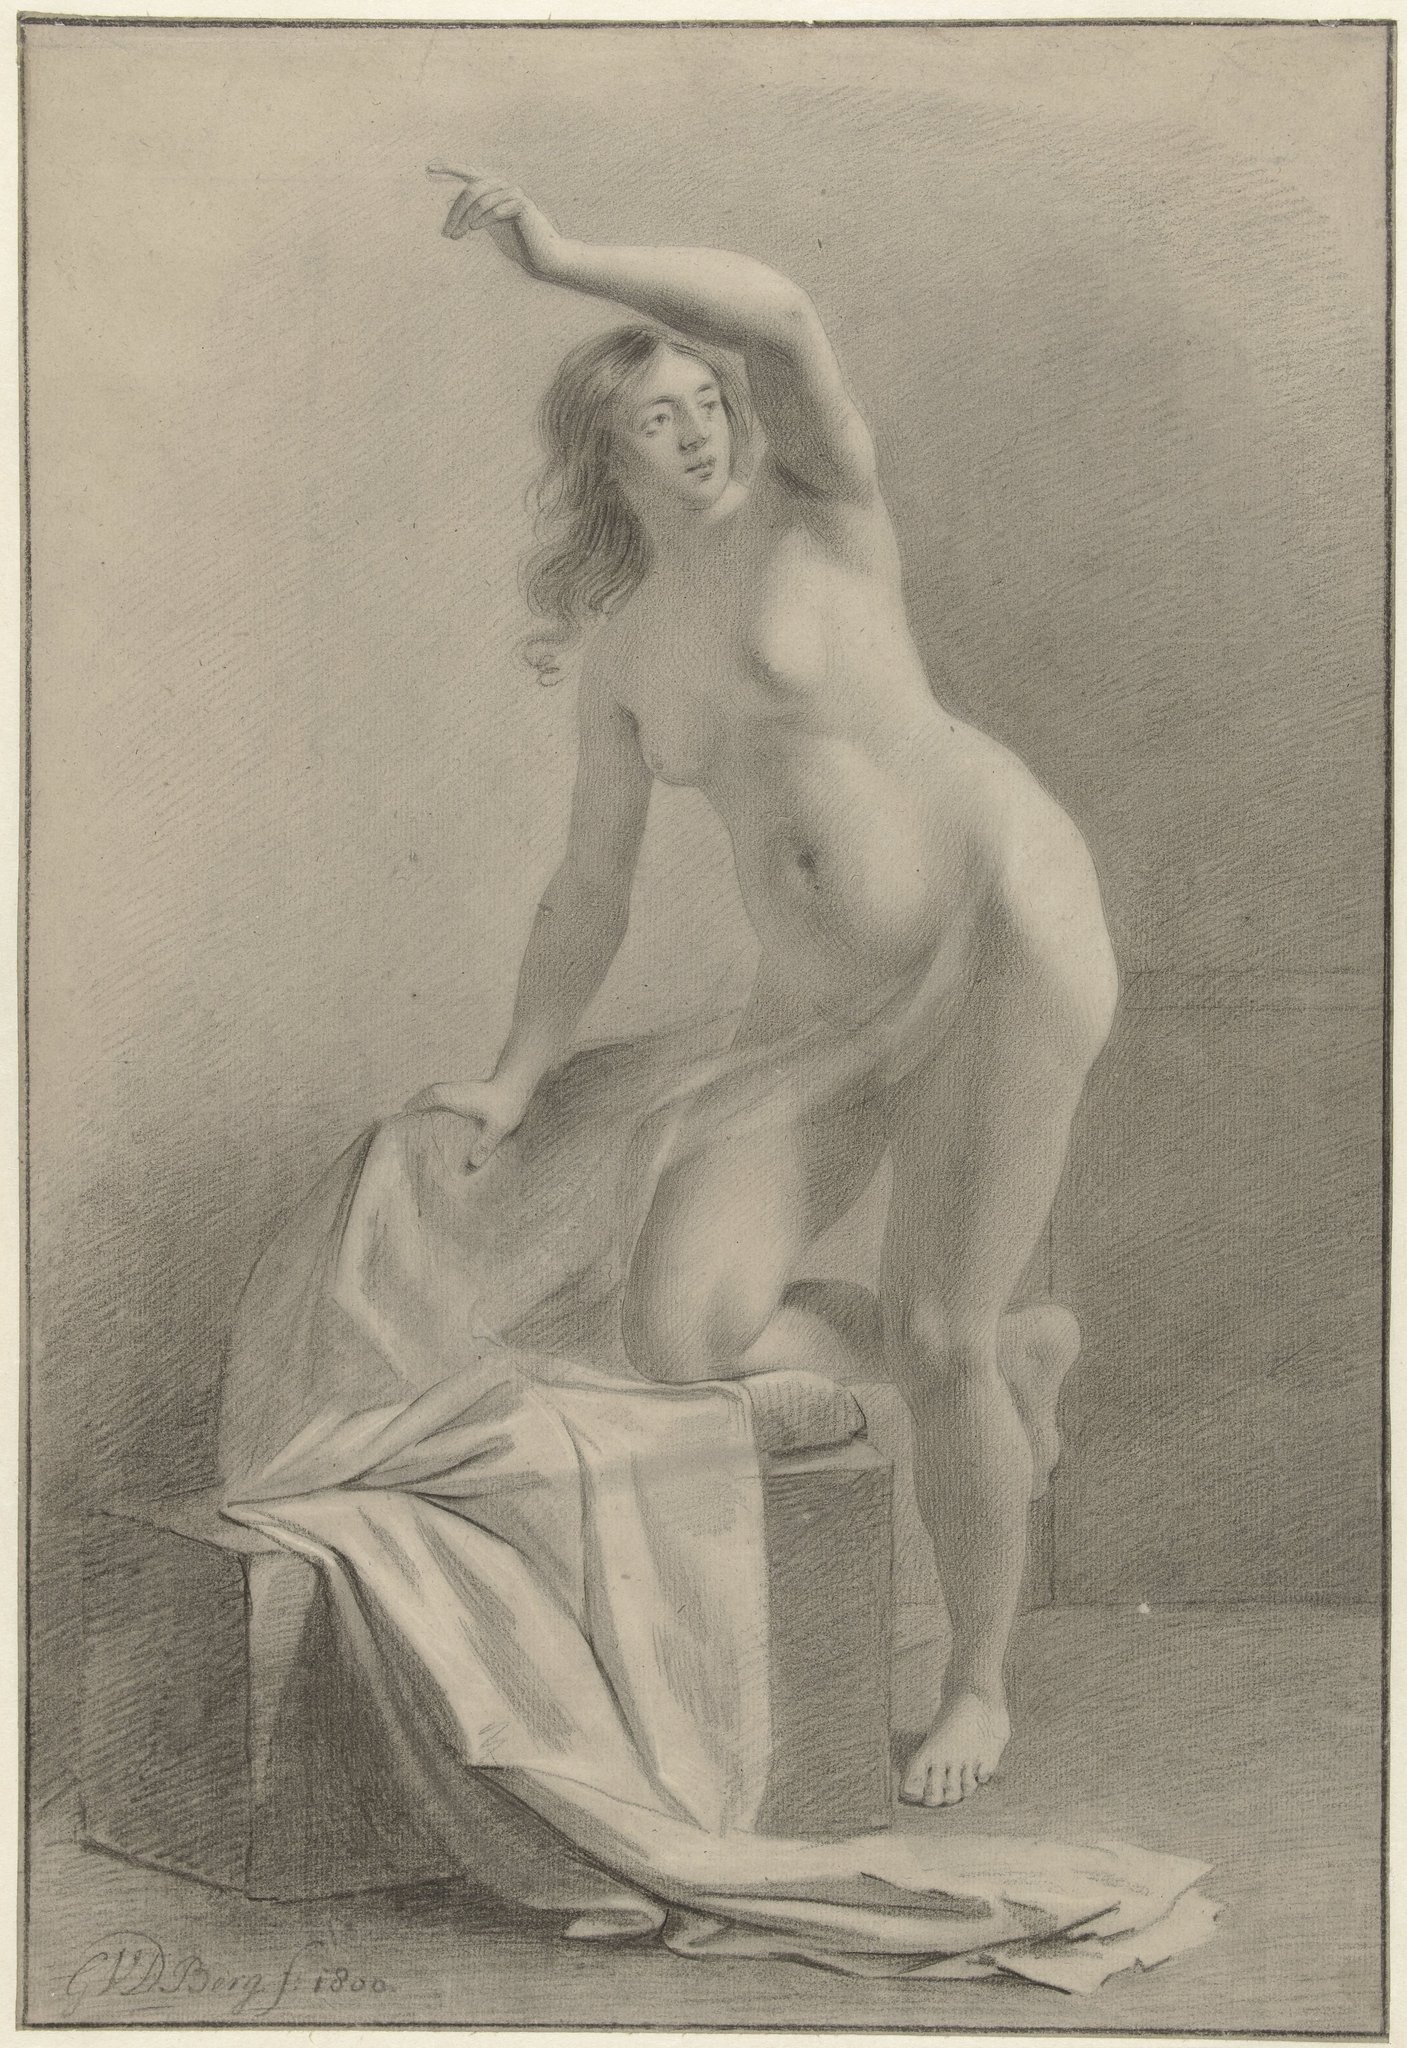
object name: drawing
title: Studie naar vrouwelijk naaktmodel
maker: gijsbertus johannus van den berg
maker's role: draughtsman, painter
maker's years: 1769-1817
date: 1800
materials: chalk, paper, pencil